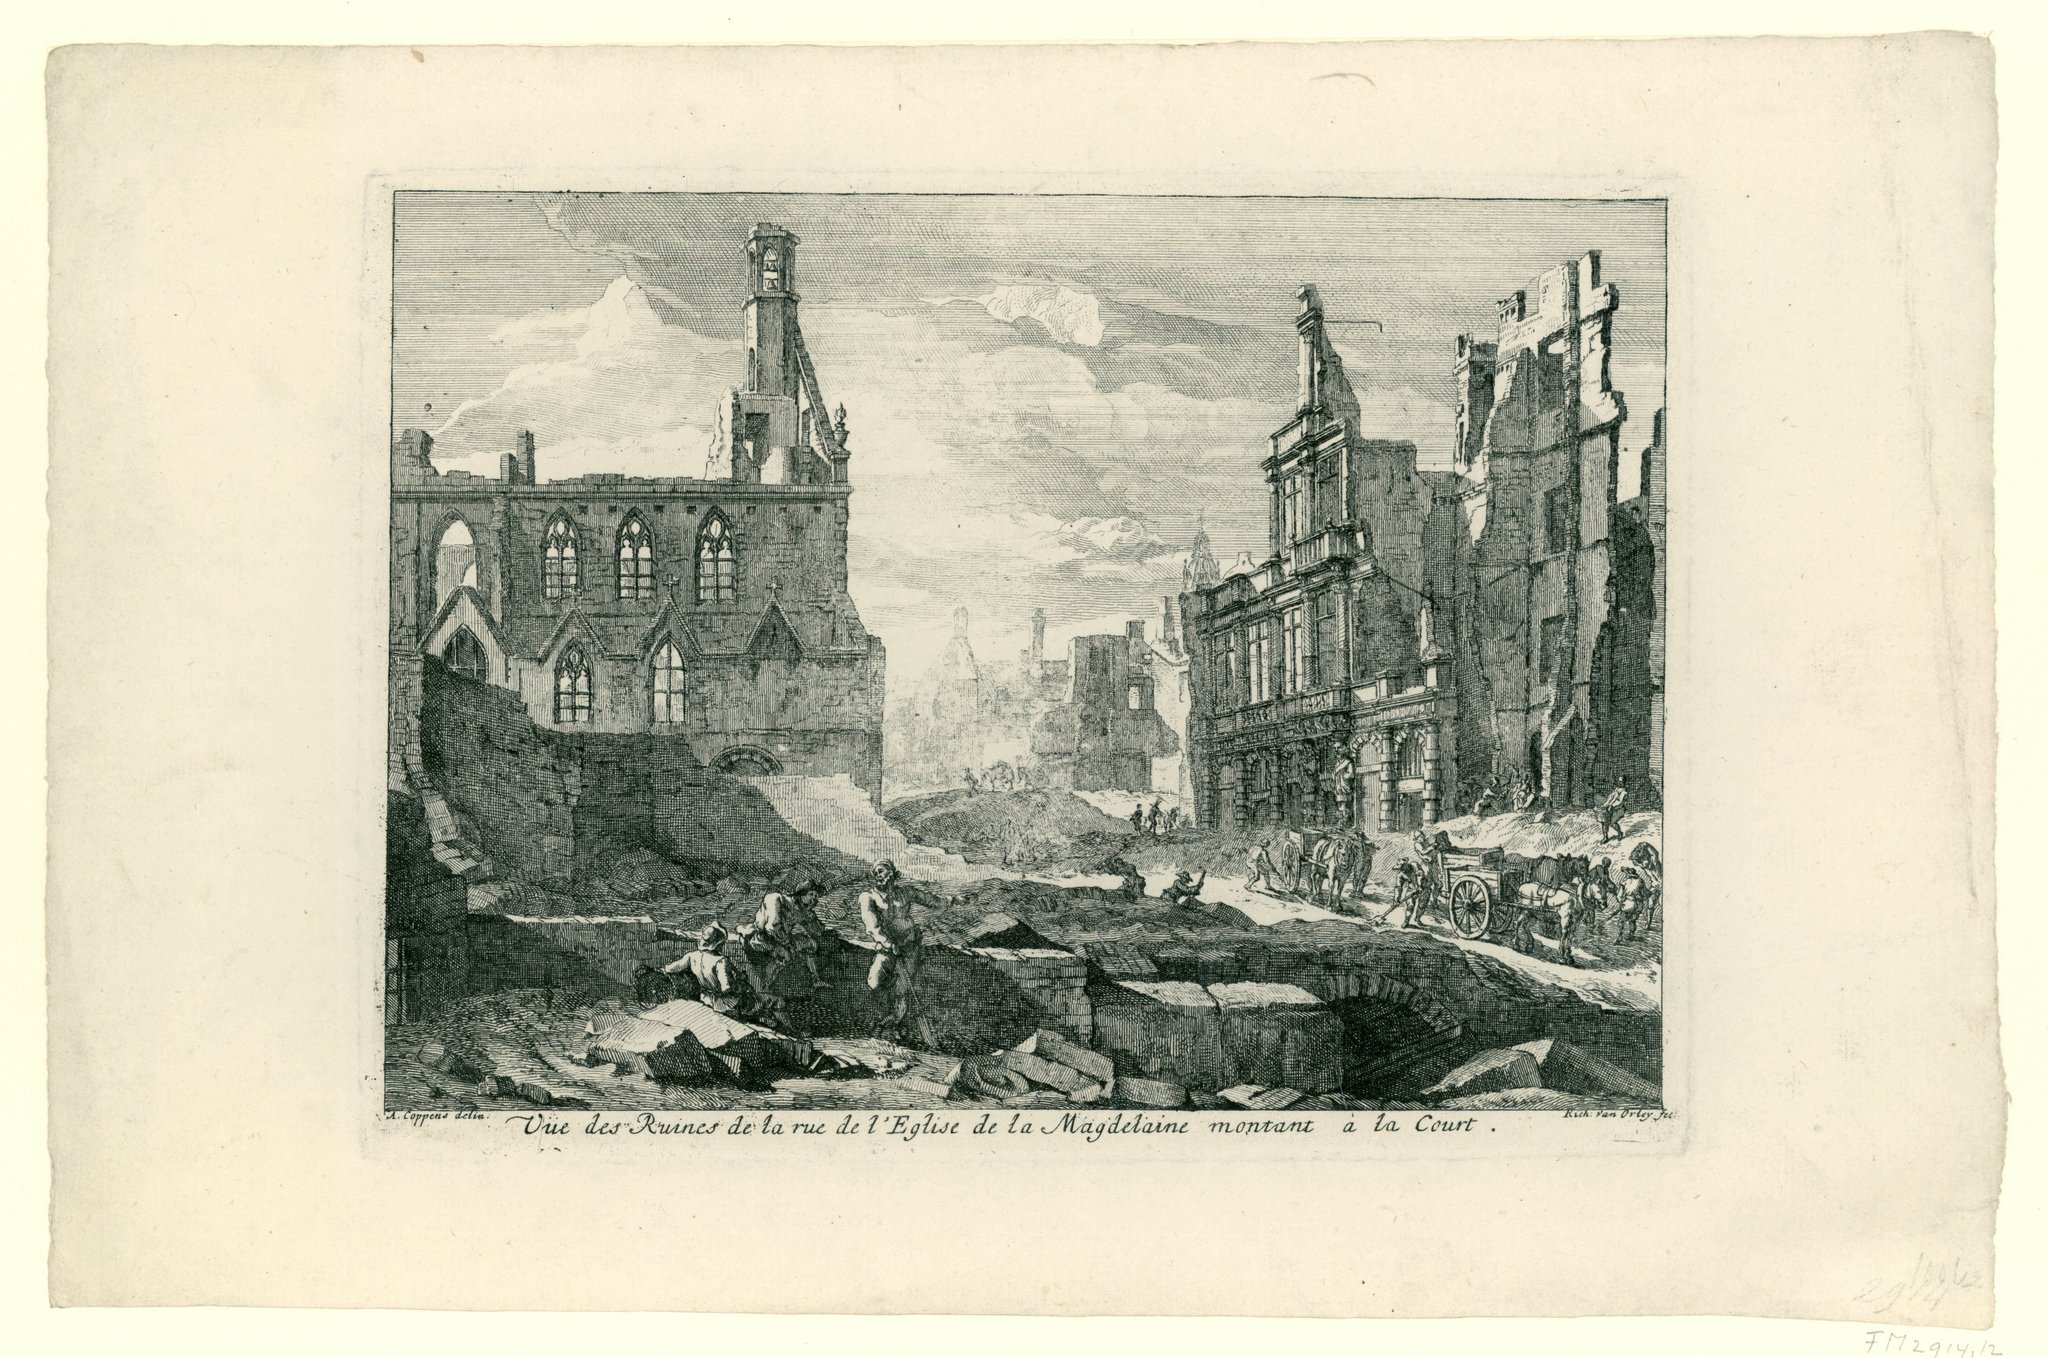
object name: print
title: Ruïnes in de Magdalenasteenweg te Brussel, 1695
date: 1695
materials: paper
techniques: etching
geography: southern netherlands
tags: devastated, ruined place or city (~ warfare), brussels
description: Voorstelling van de ruïnes in de Magdalenasteenweg te Brussel na het bombardement door de Fransen, 13-15 augustus 1695. Twaalfde prent in de reeks van twaalf.